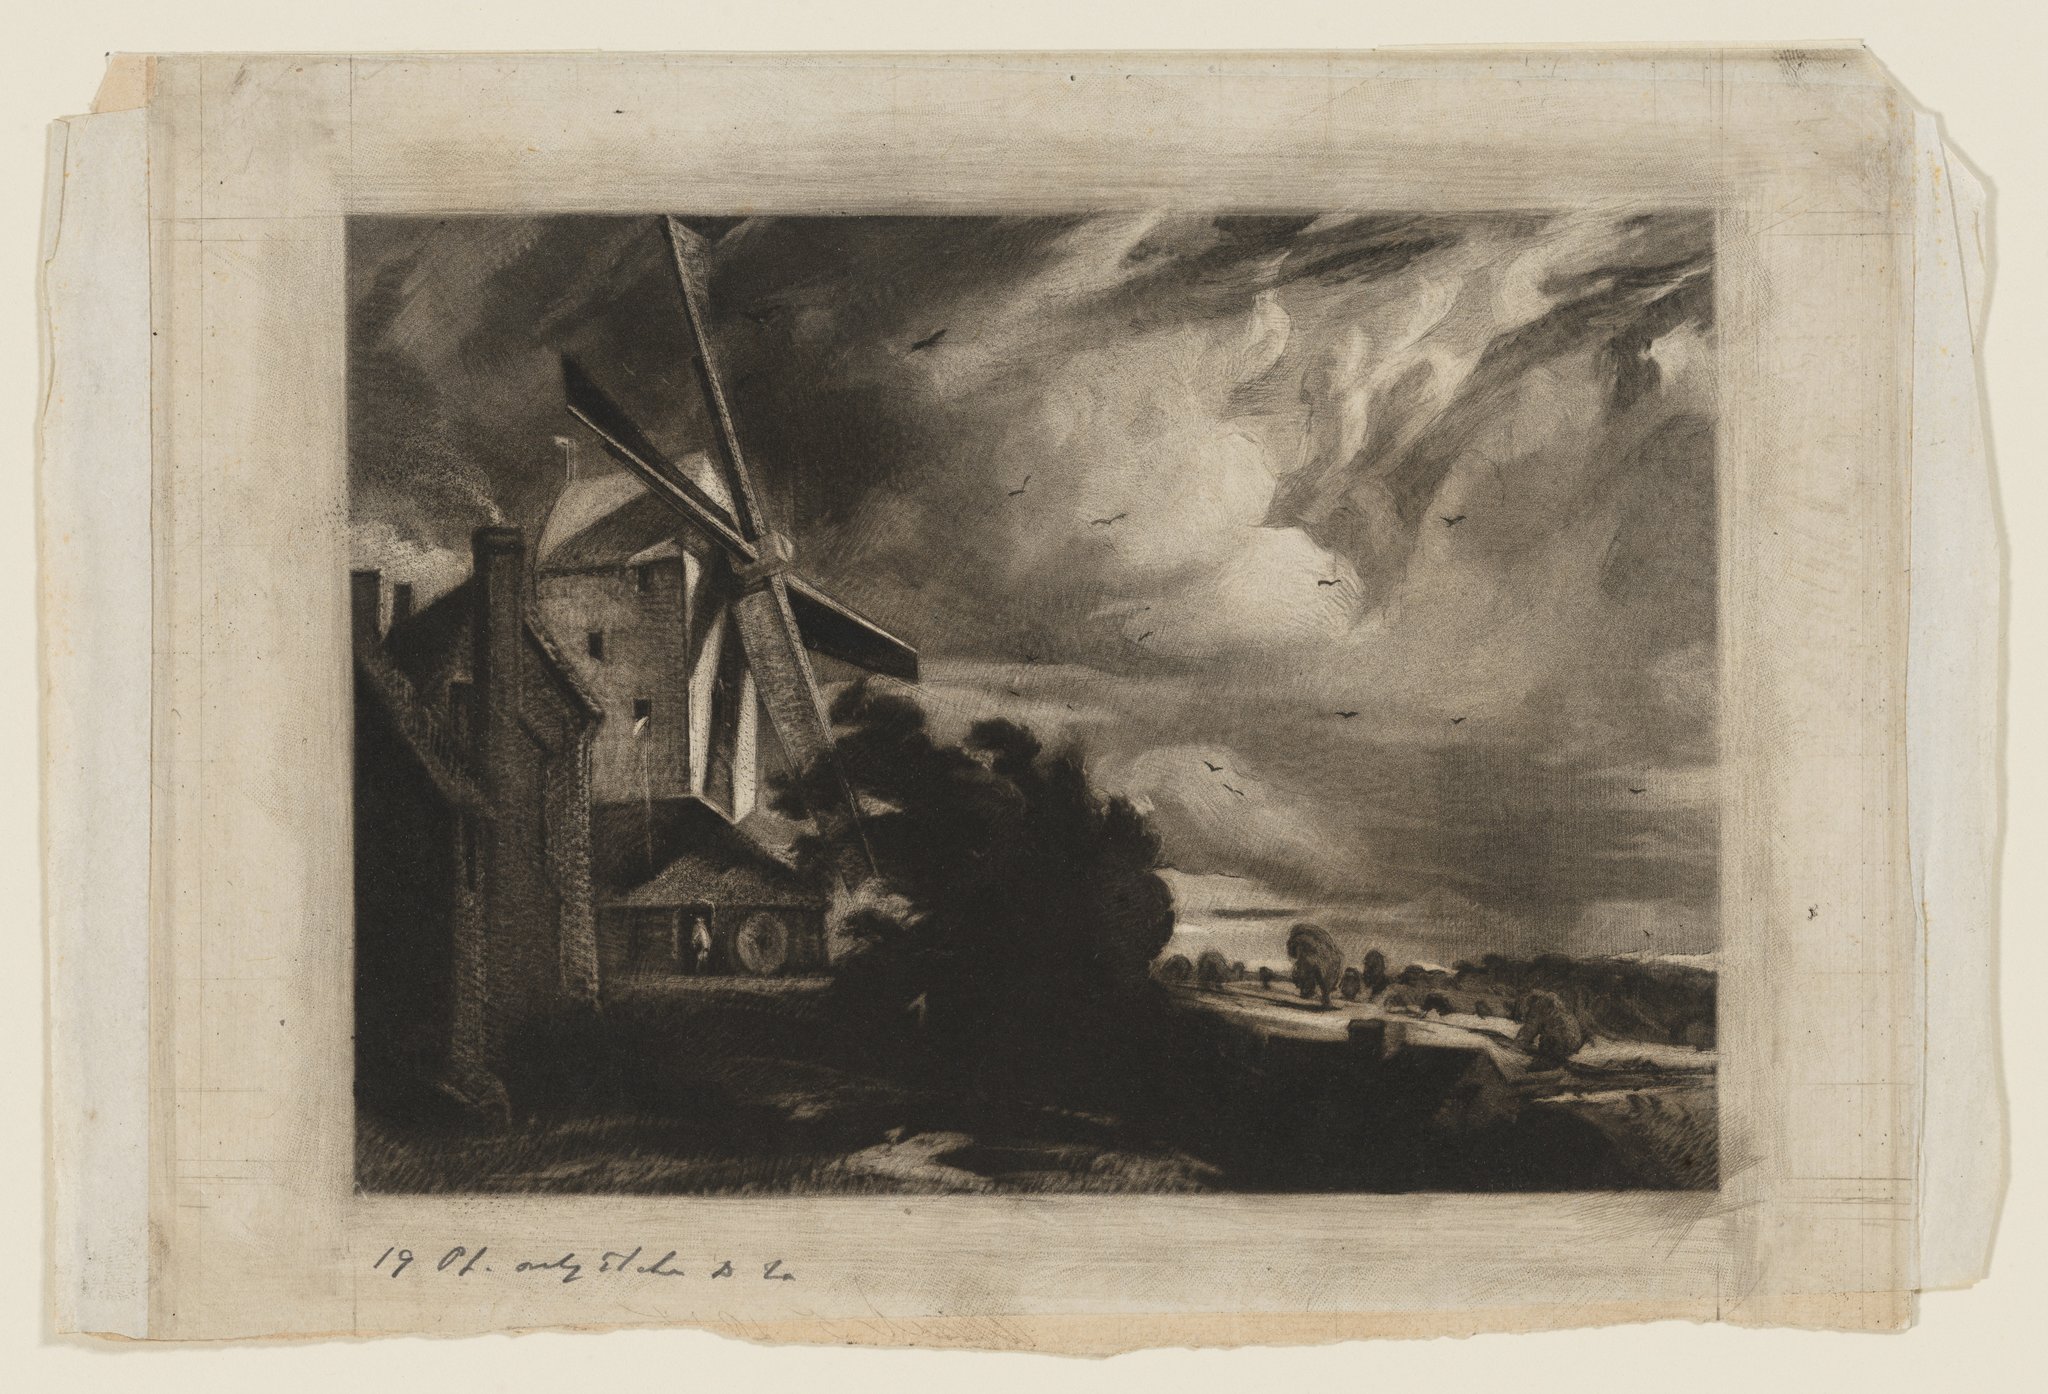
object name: print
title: Mill near Colchester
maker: david lucas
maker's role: engraver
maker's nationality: british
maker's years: 1802-1881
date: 1845-1846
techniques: mezzotint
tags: windmills